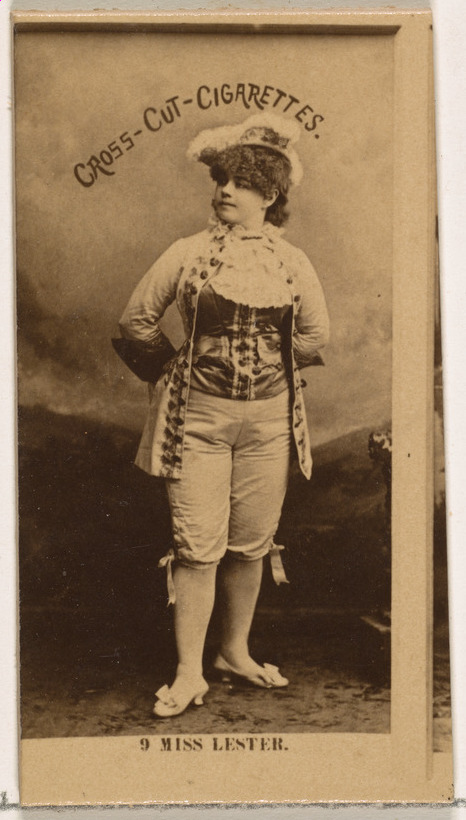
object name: print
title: Card Number 9, Miss Lester, from the Actors and Actresses series (N145-2) issued by Duke Sons & Co. to promote Cross Cut Cigarettes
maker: w. duke, sons & co.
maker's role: publisher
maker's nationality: american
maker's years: 1870-1920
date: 1880-1889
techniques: albumen silver print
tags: portraits,women,actresses